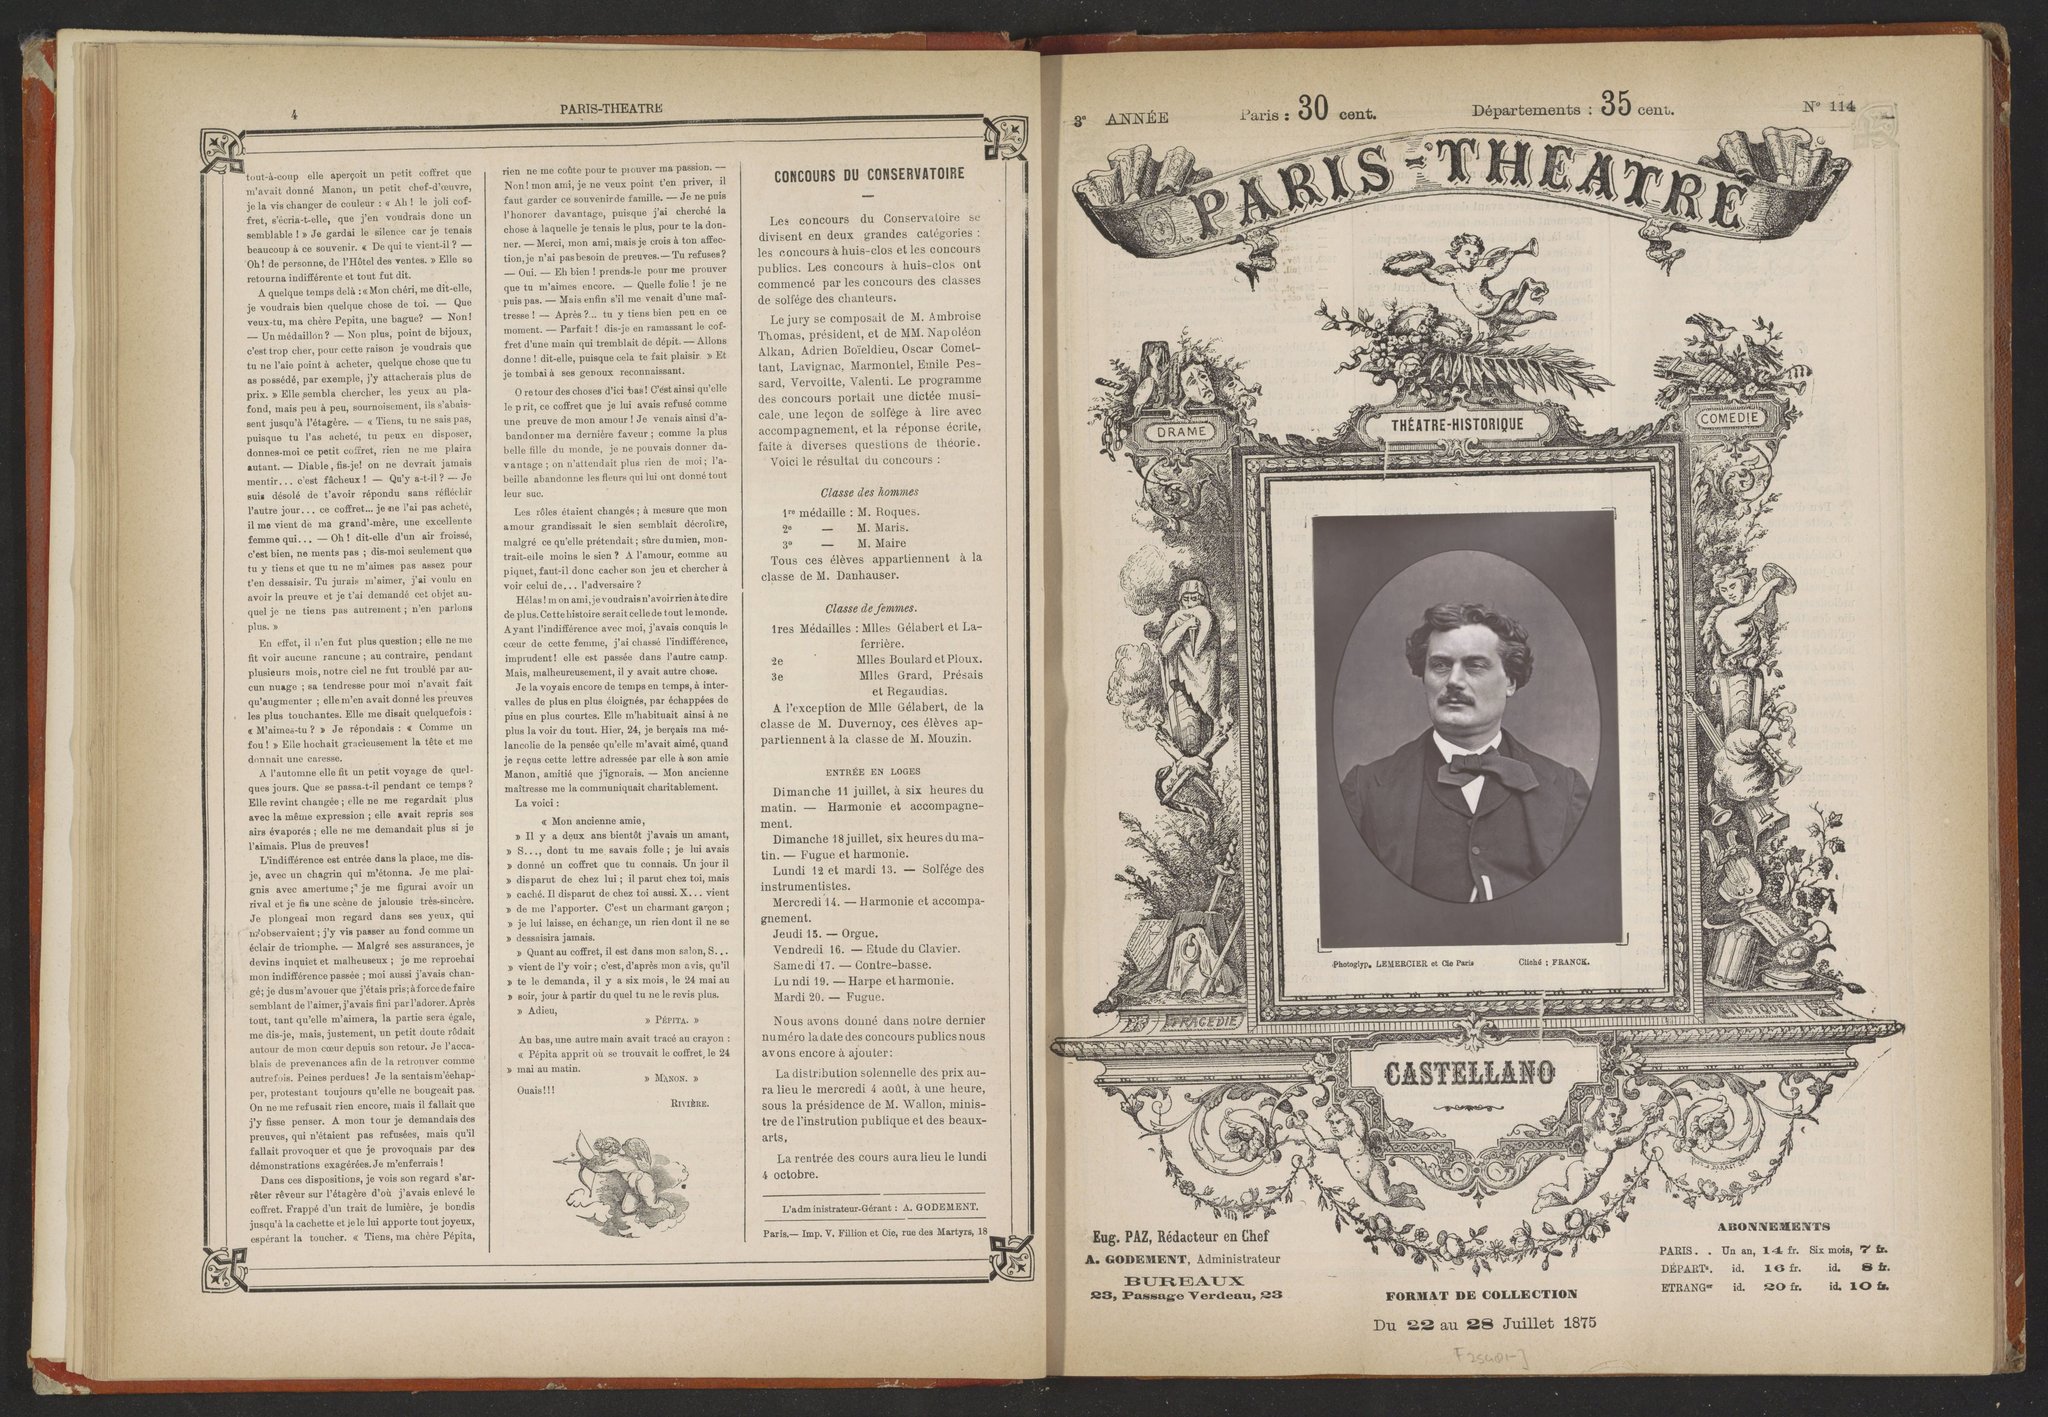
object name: page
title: Castellano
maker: françois marie louis franck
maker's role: fotograaf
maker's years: 1816-1906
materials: paper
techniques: woodburytype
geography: france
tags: portrait of actor, actress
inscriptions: inscription: ‘Du 22 au 28 Juillet 1875’, number: ‘No 114’